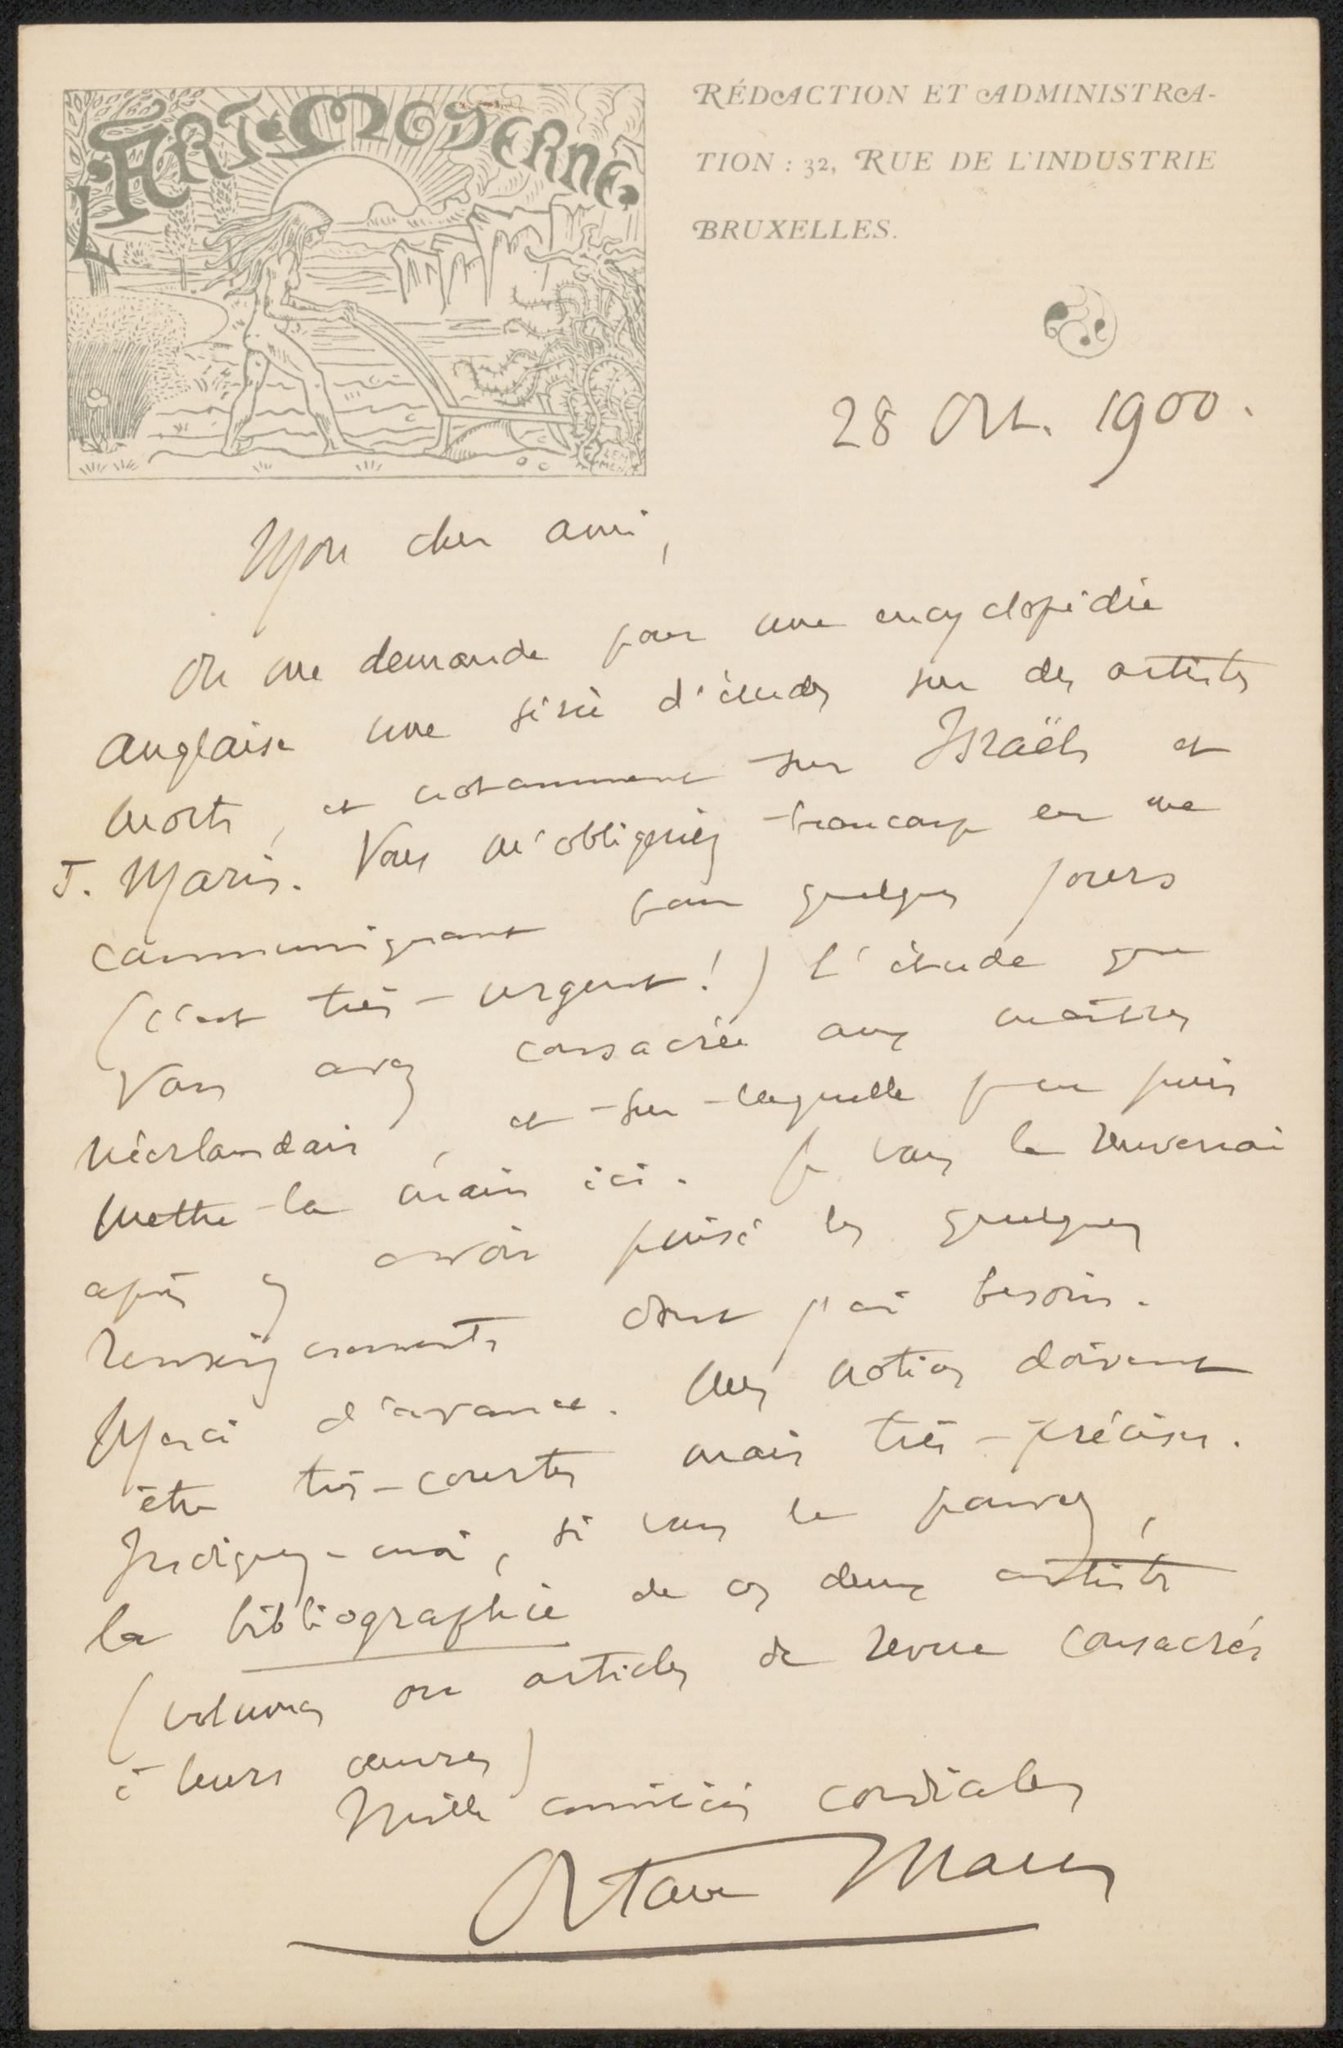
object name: letter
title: Brief aan Philip Zilcken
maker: octave maus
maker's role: painter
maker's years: 1856-1919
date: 1900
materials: ink, paper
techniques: pen, printing, writing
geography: brussels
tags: the hague, painter, draughtsman, jacob maris, philip zilcken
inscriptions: watermark, collector's mark: ‘RPK’